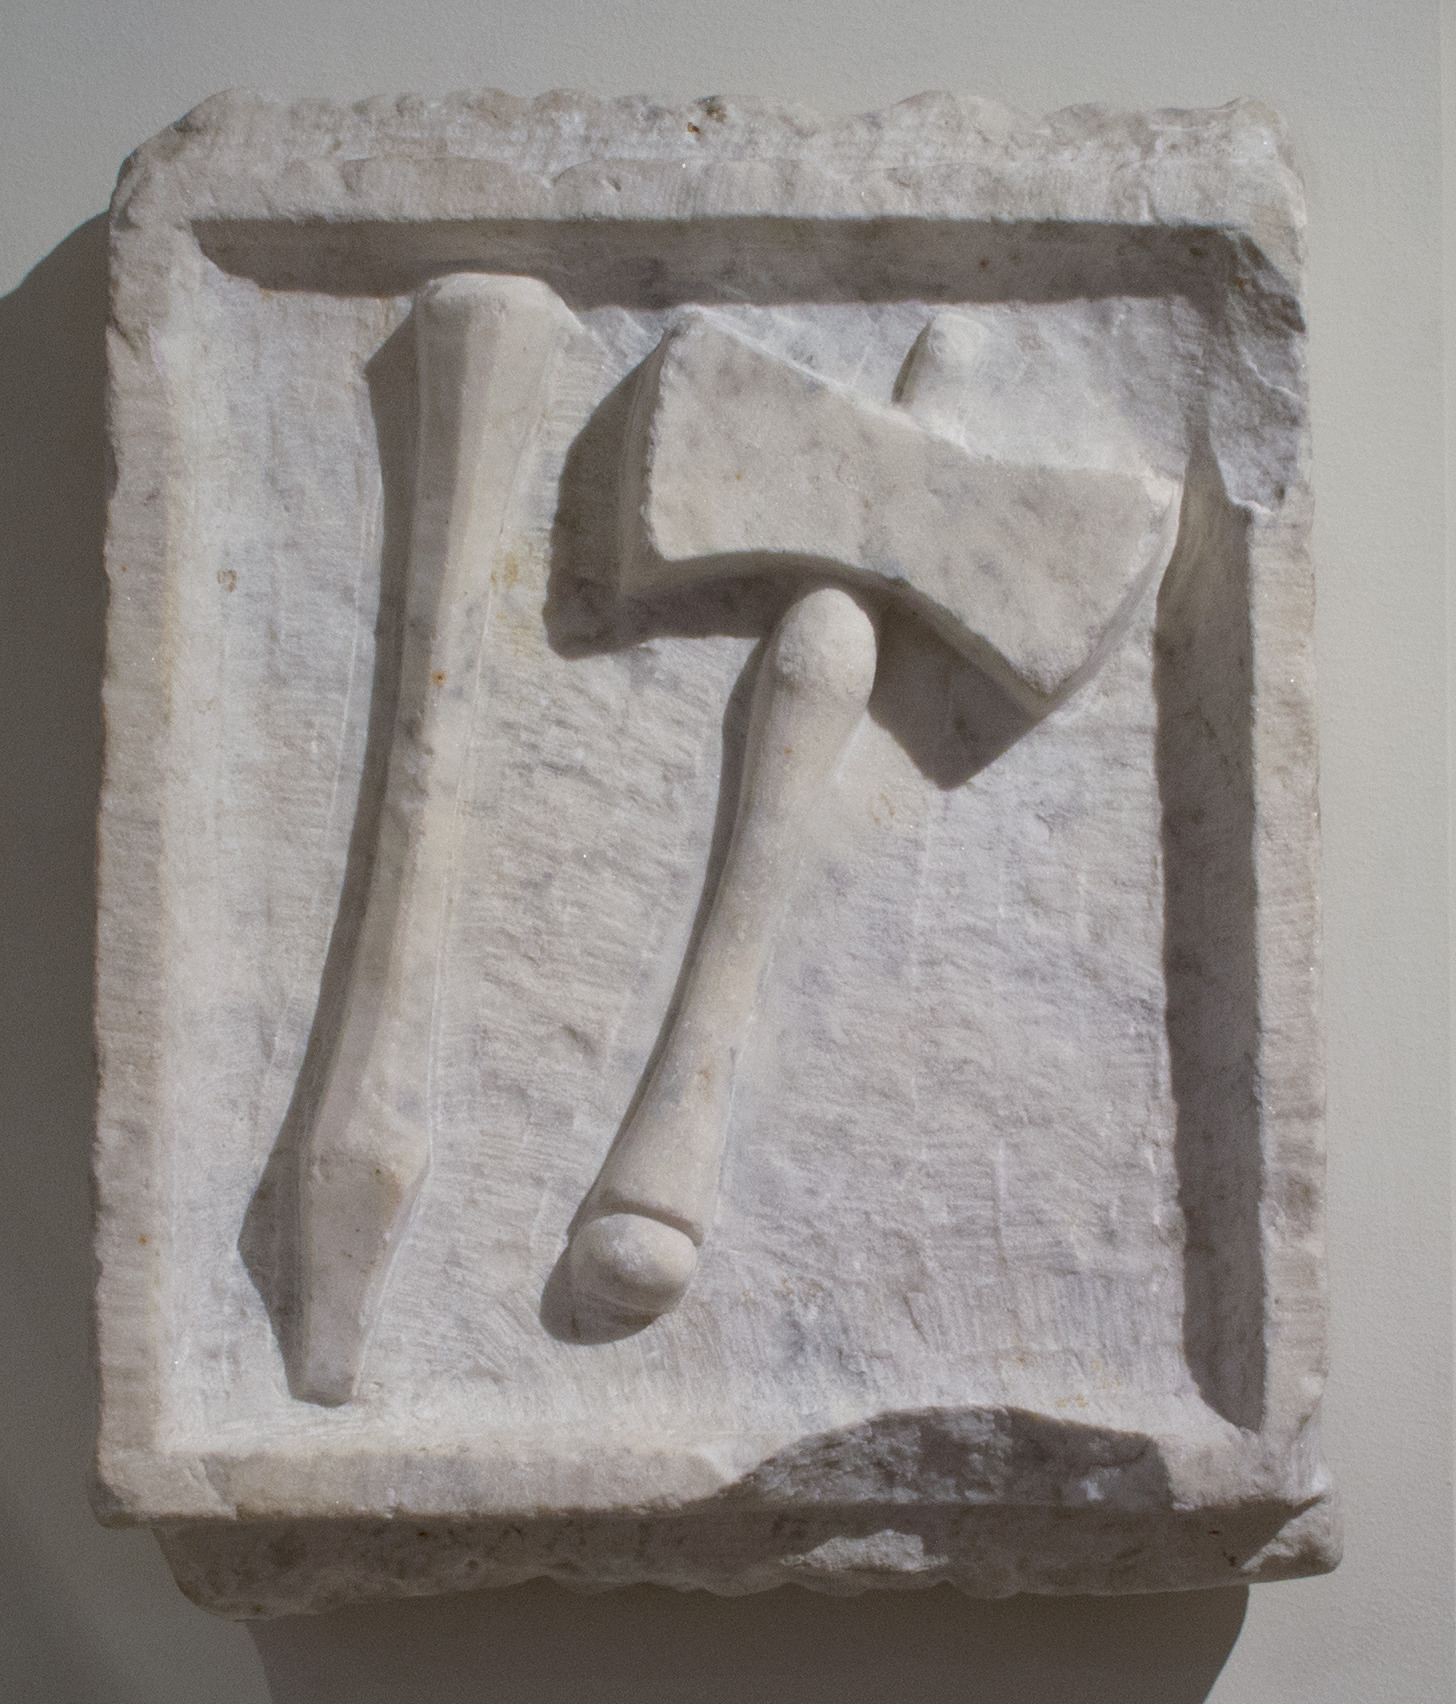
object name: relief of a mallet and chisel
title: Marble relief of a chisel and mallet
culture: roman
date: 101-200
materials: marble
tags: tools